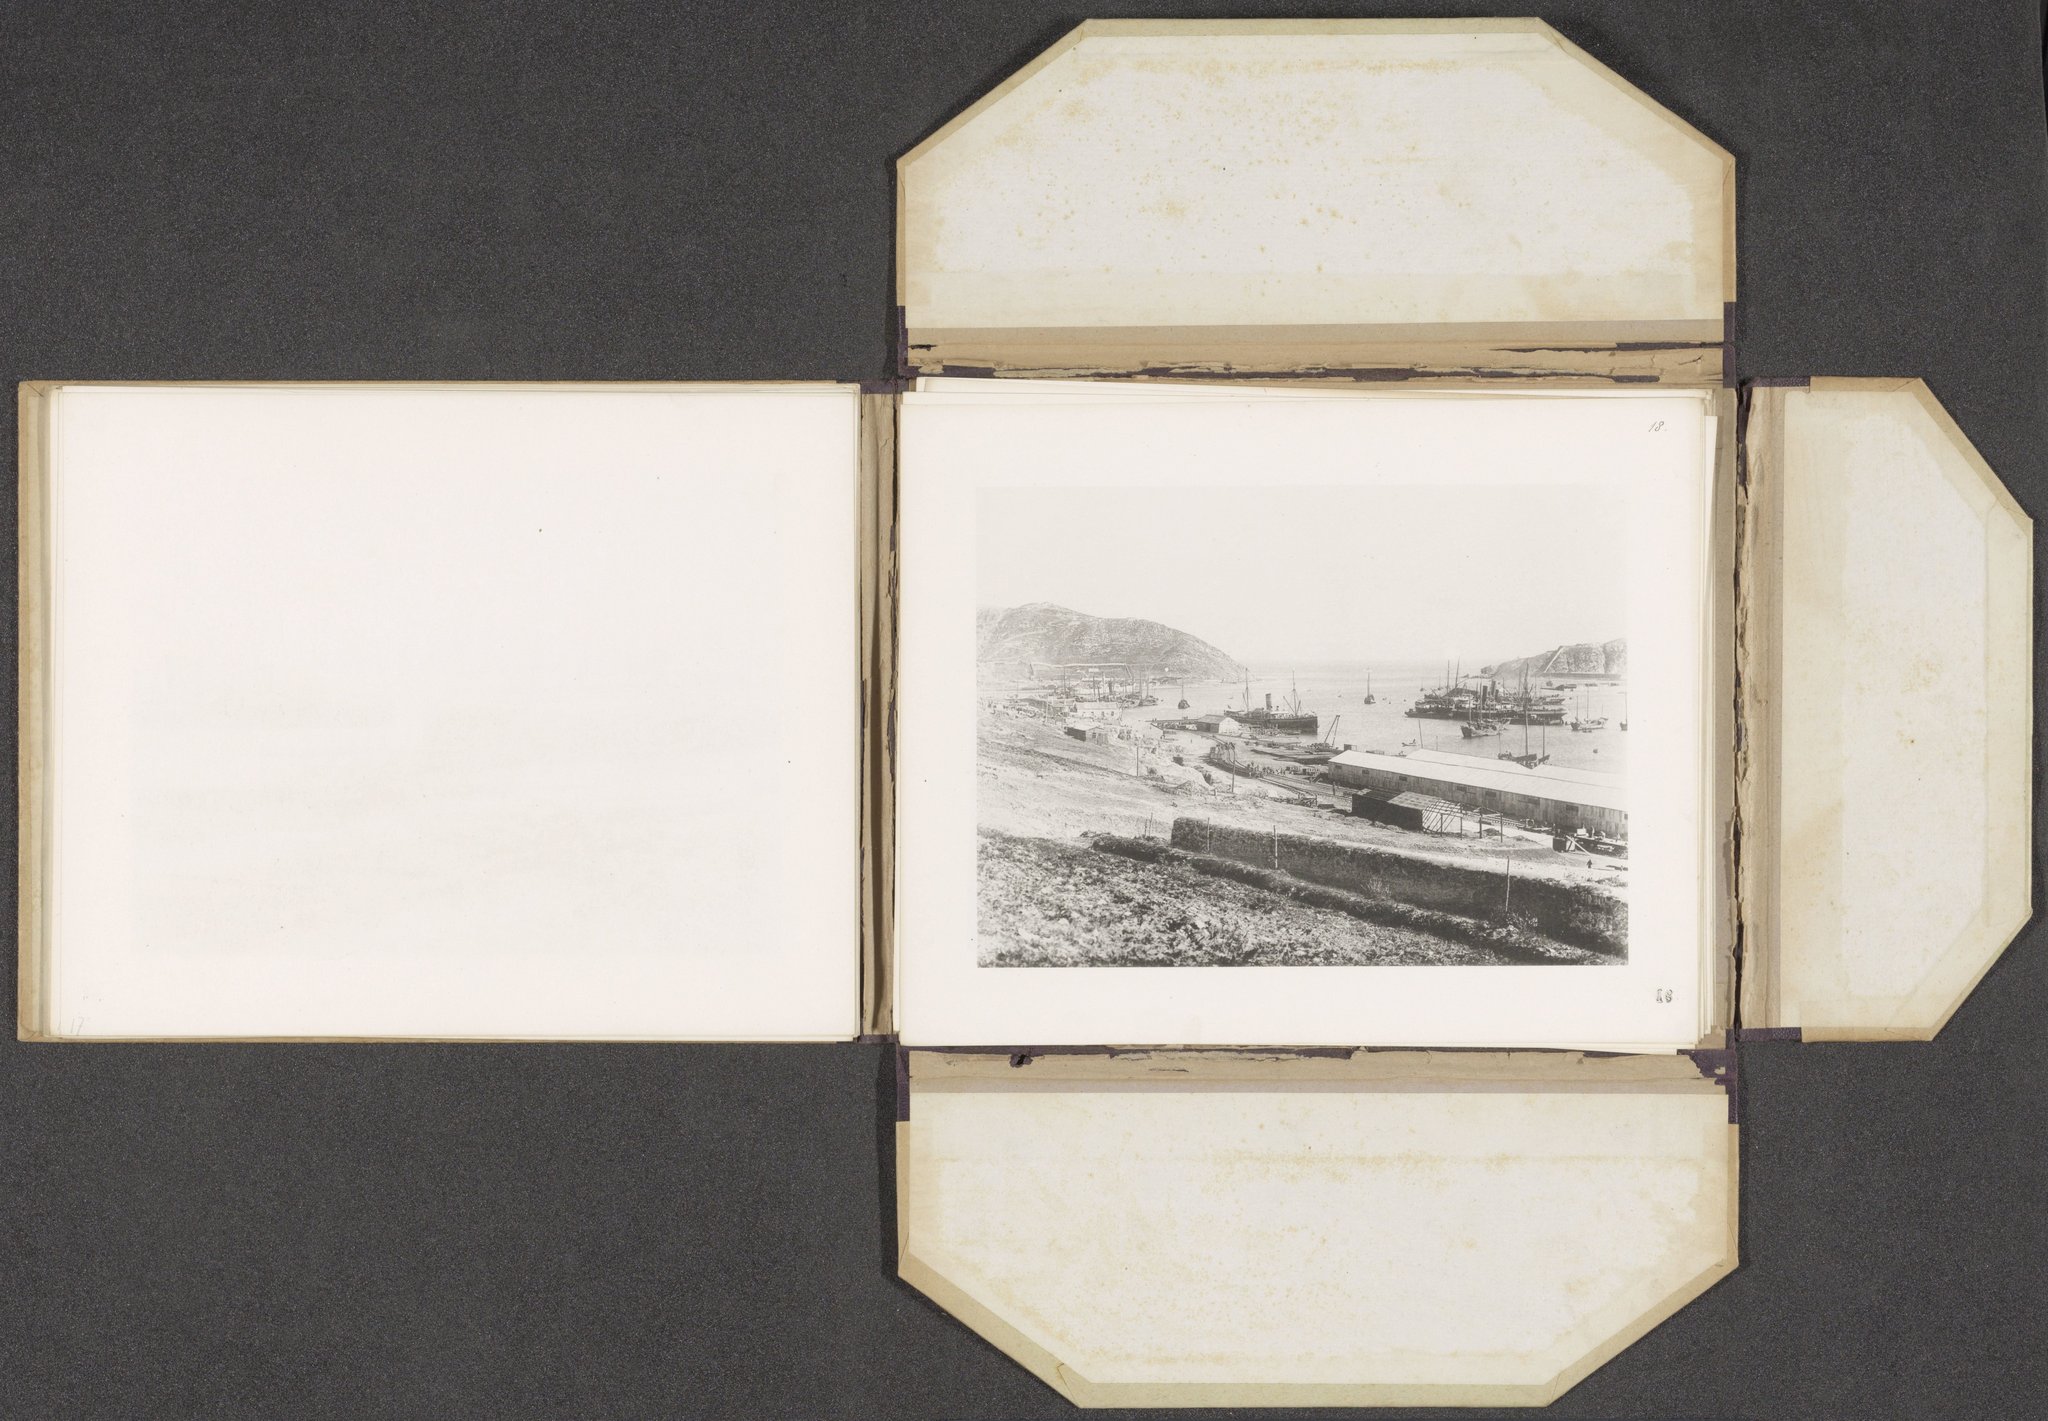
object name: photomechanical print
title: Gezicht op de Oost-Chinese spoorlijn te Port Arthur, met zicht op de baai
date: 1898-1899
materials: paper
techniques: photograph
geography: port arthur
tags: gulf, bay, ships (in general), railway, tramway; rack railway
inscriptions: number: ‘18’